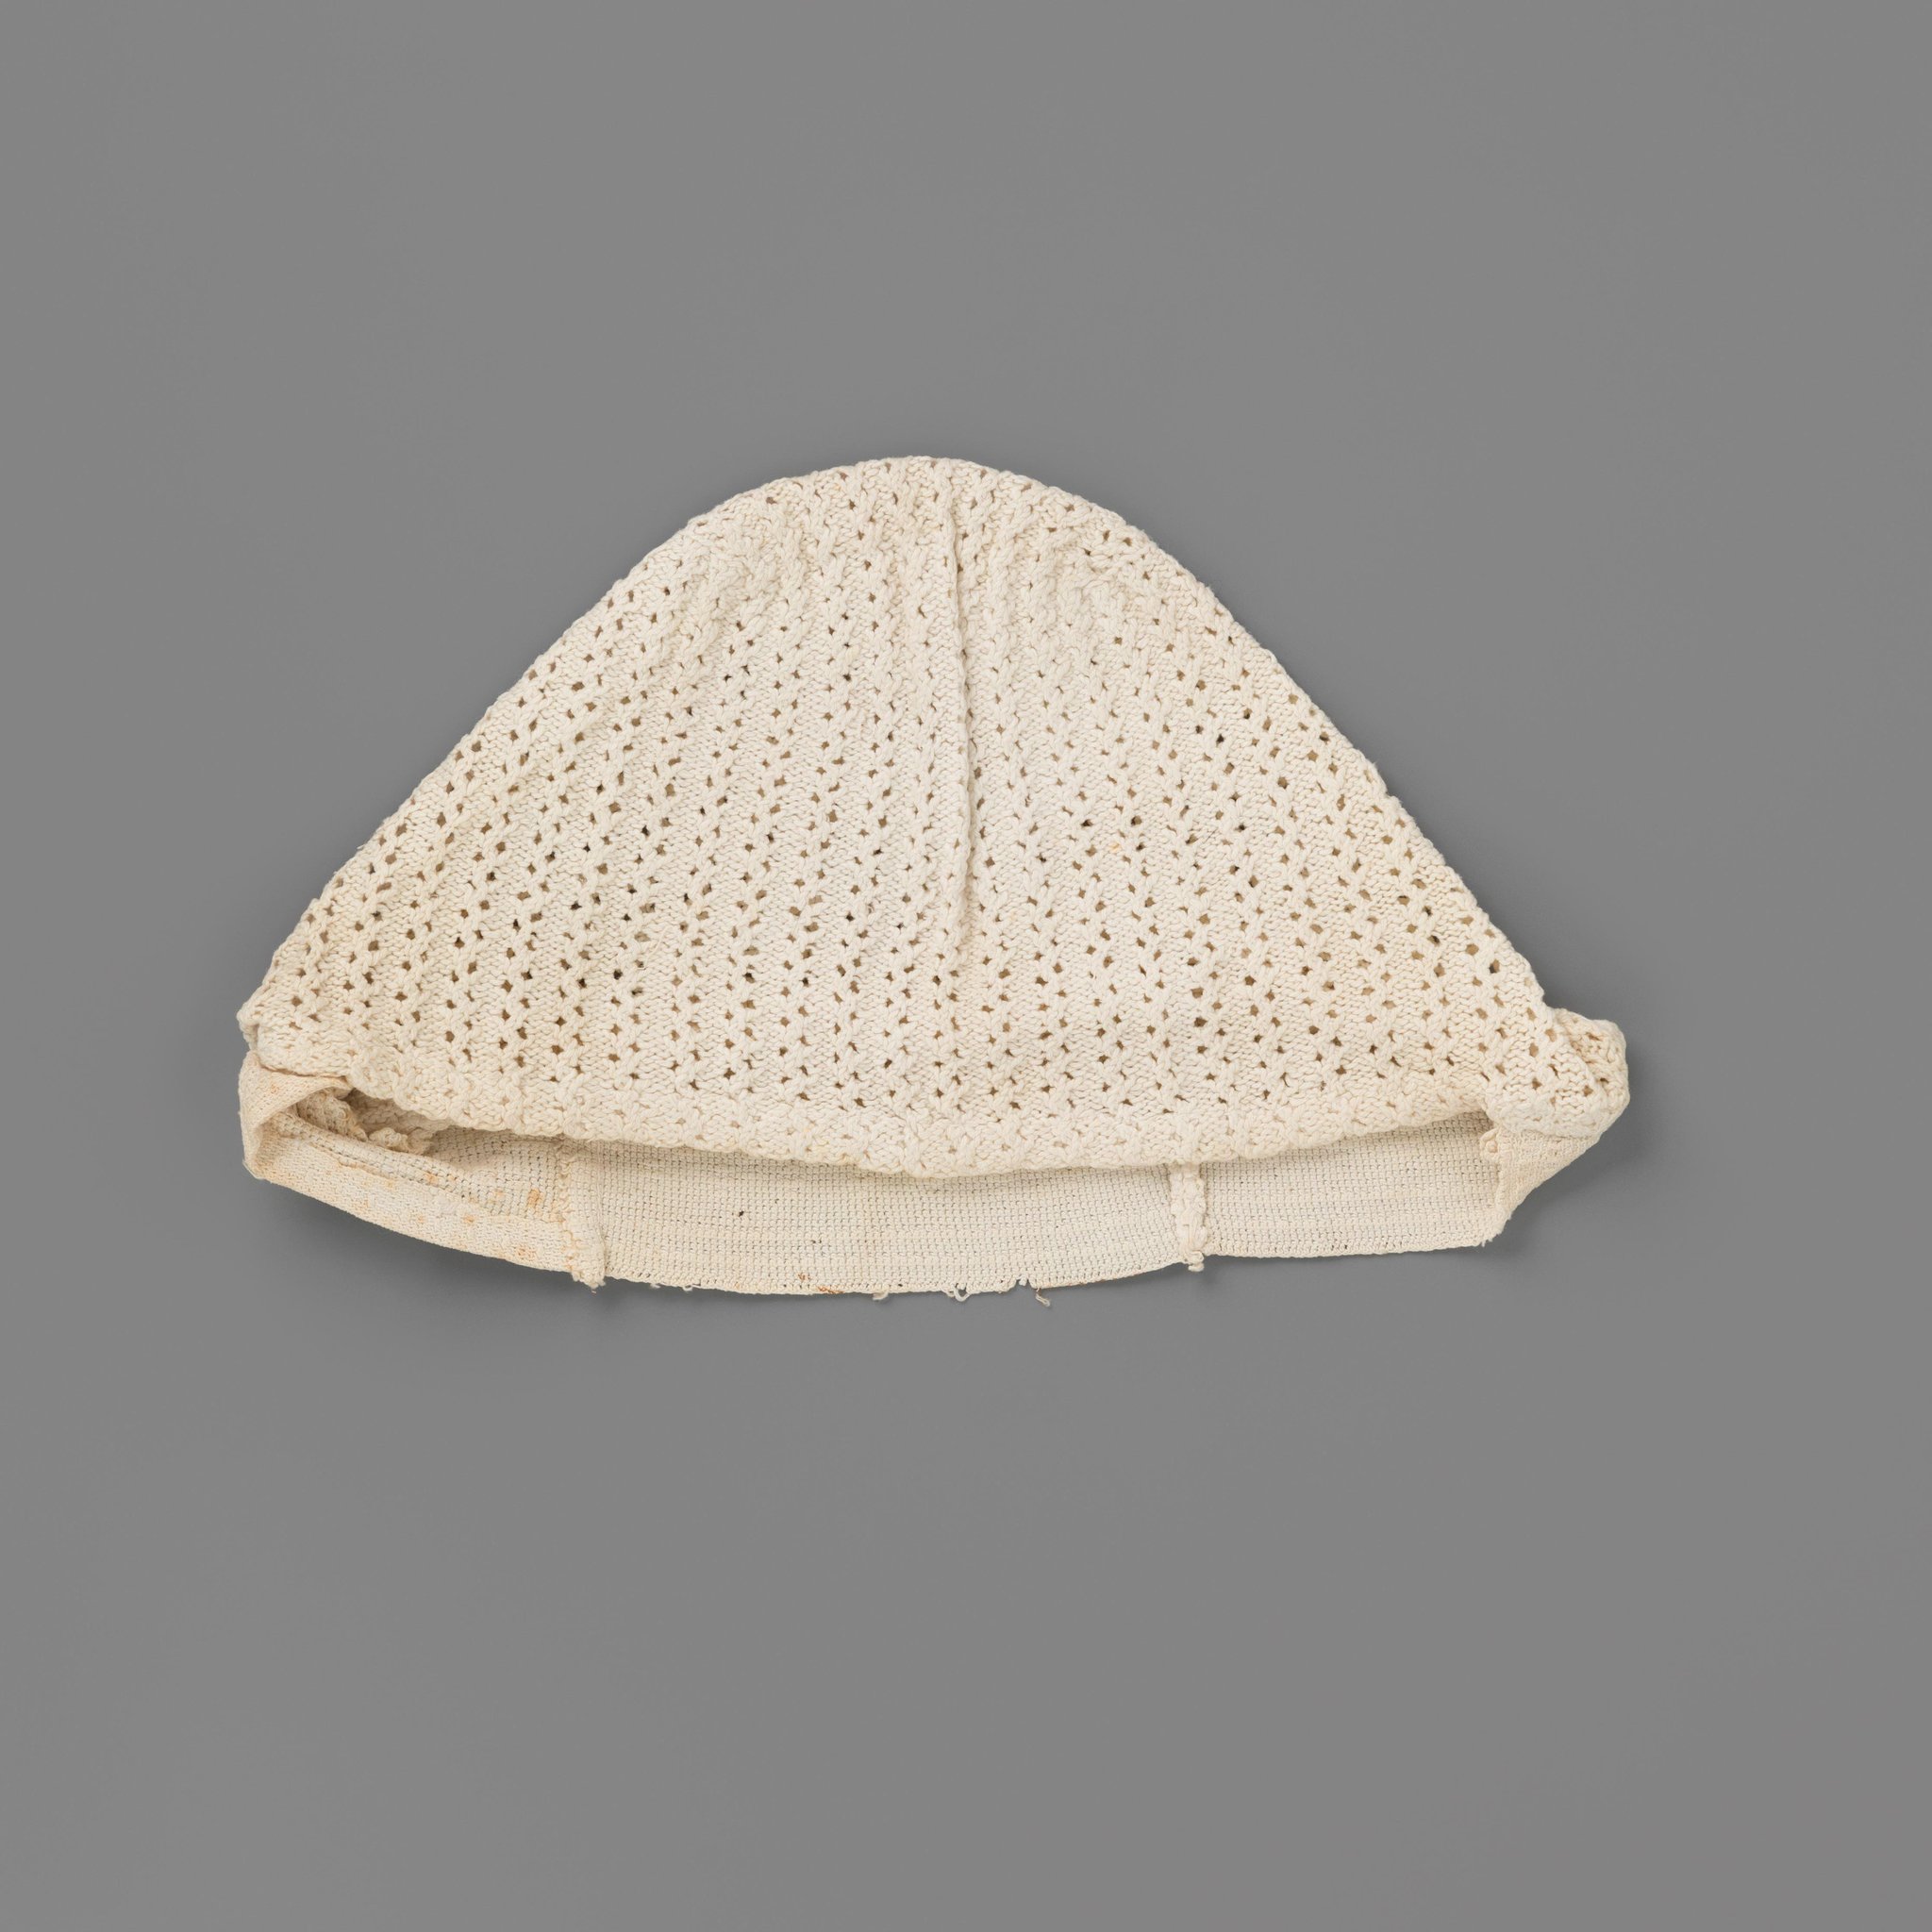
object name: womenswear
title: Muts van gebreide katoen, met langs het voorhoofd een strook met fijnere structuur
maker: Anonymous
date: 1800-1900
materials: cotton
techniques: knitting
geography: friesland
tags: head-gear: cap (+ men's clothes)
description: Muts van gebreide katoen. De bol van is langs het voorhoofd afgezet met een strook met fijnere struktuur. Voor daagse- of onderdracht.